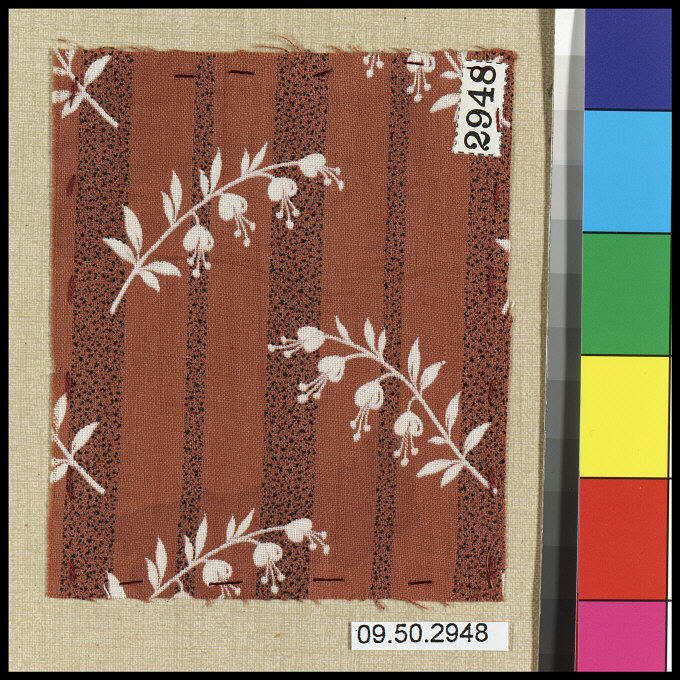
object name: piece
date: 1801-1900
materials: cotton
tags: leaves